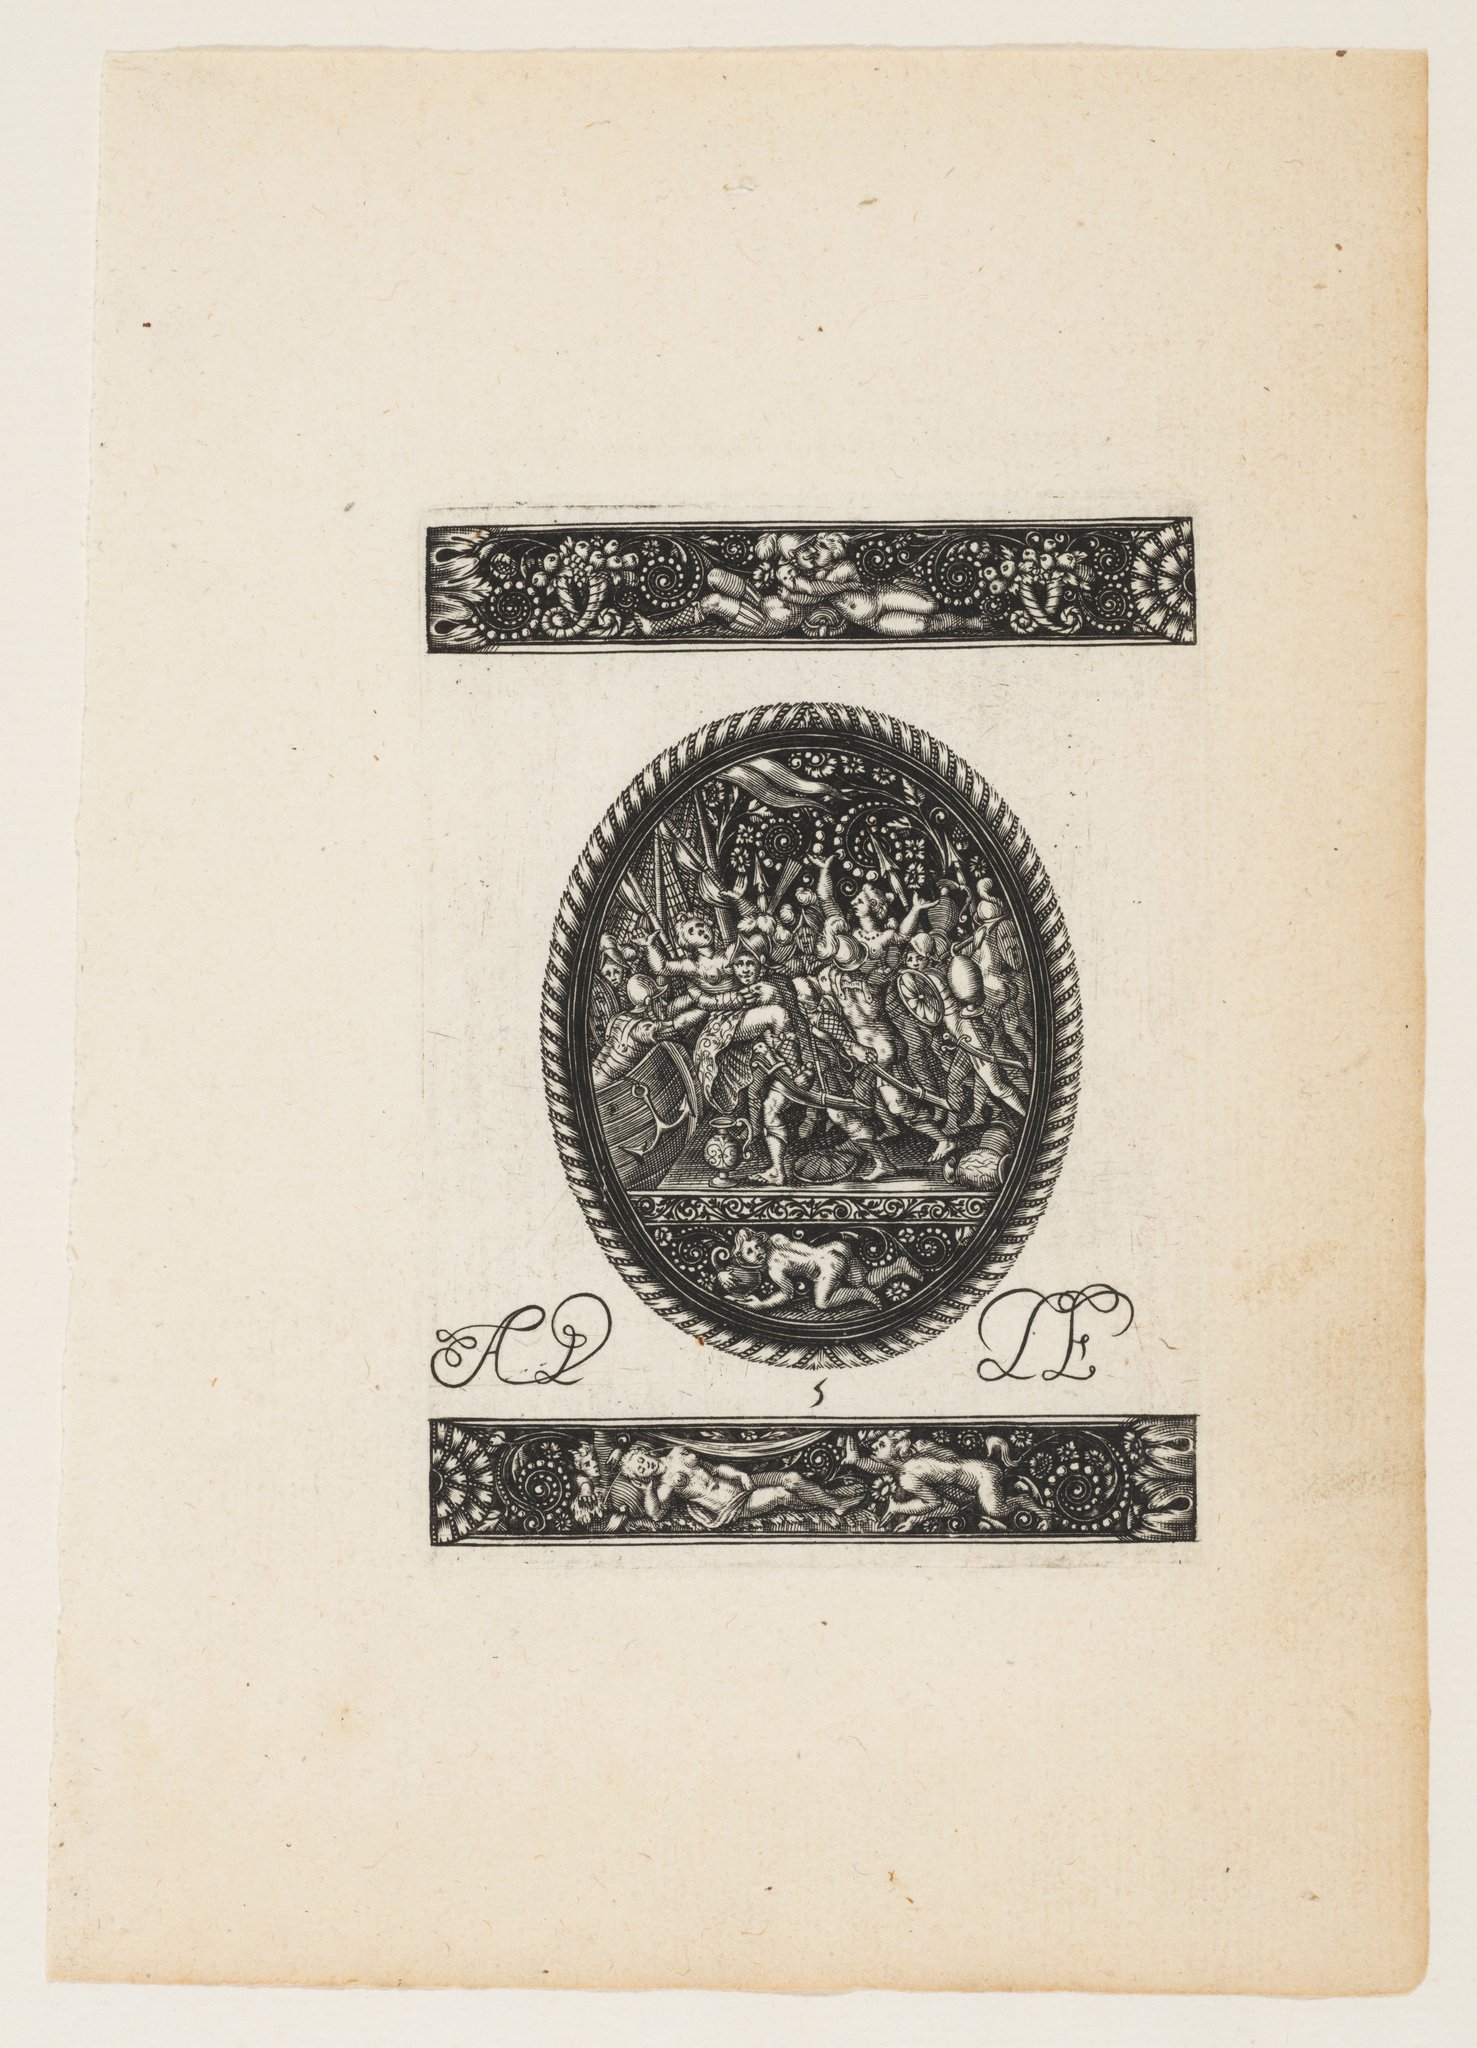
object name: ornament architectue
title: Oval Watch Case with the Abduction of Helen of Troy (?), from a Series of Six Designs for Watch Cases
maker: antoine jacquard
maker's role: artist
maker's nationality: french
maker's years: 1610-1630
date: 1610-1615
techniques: embroidery, engraving